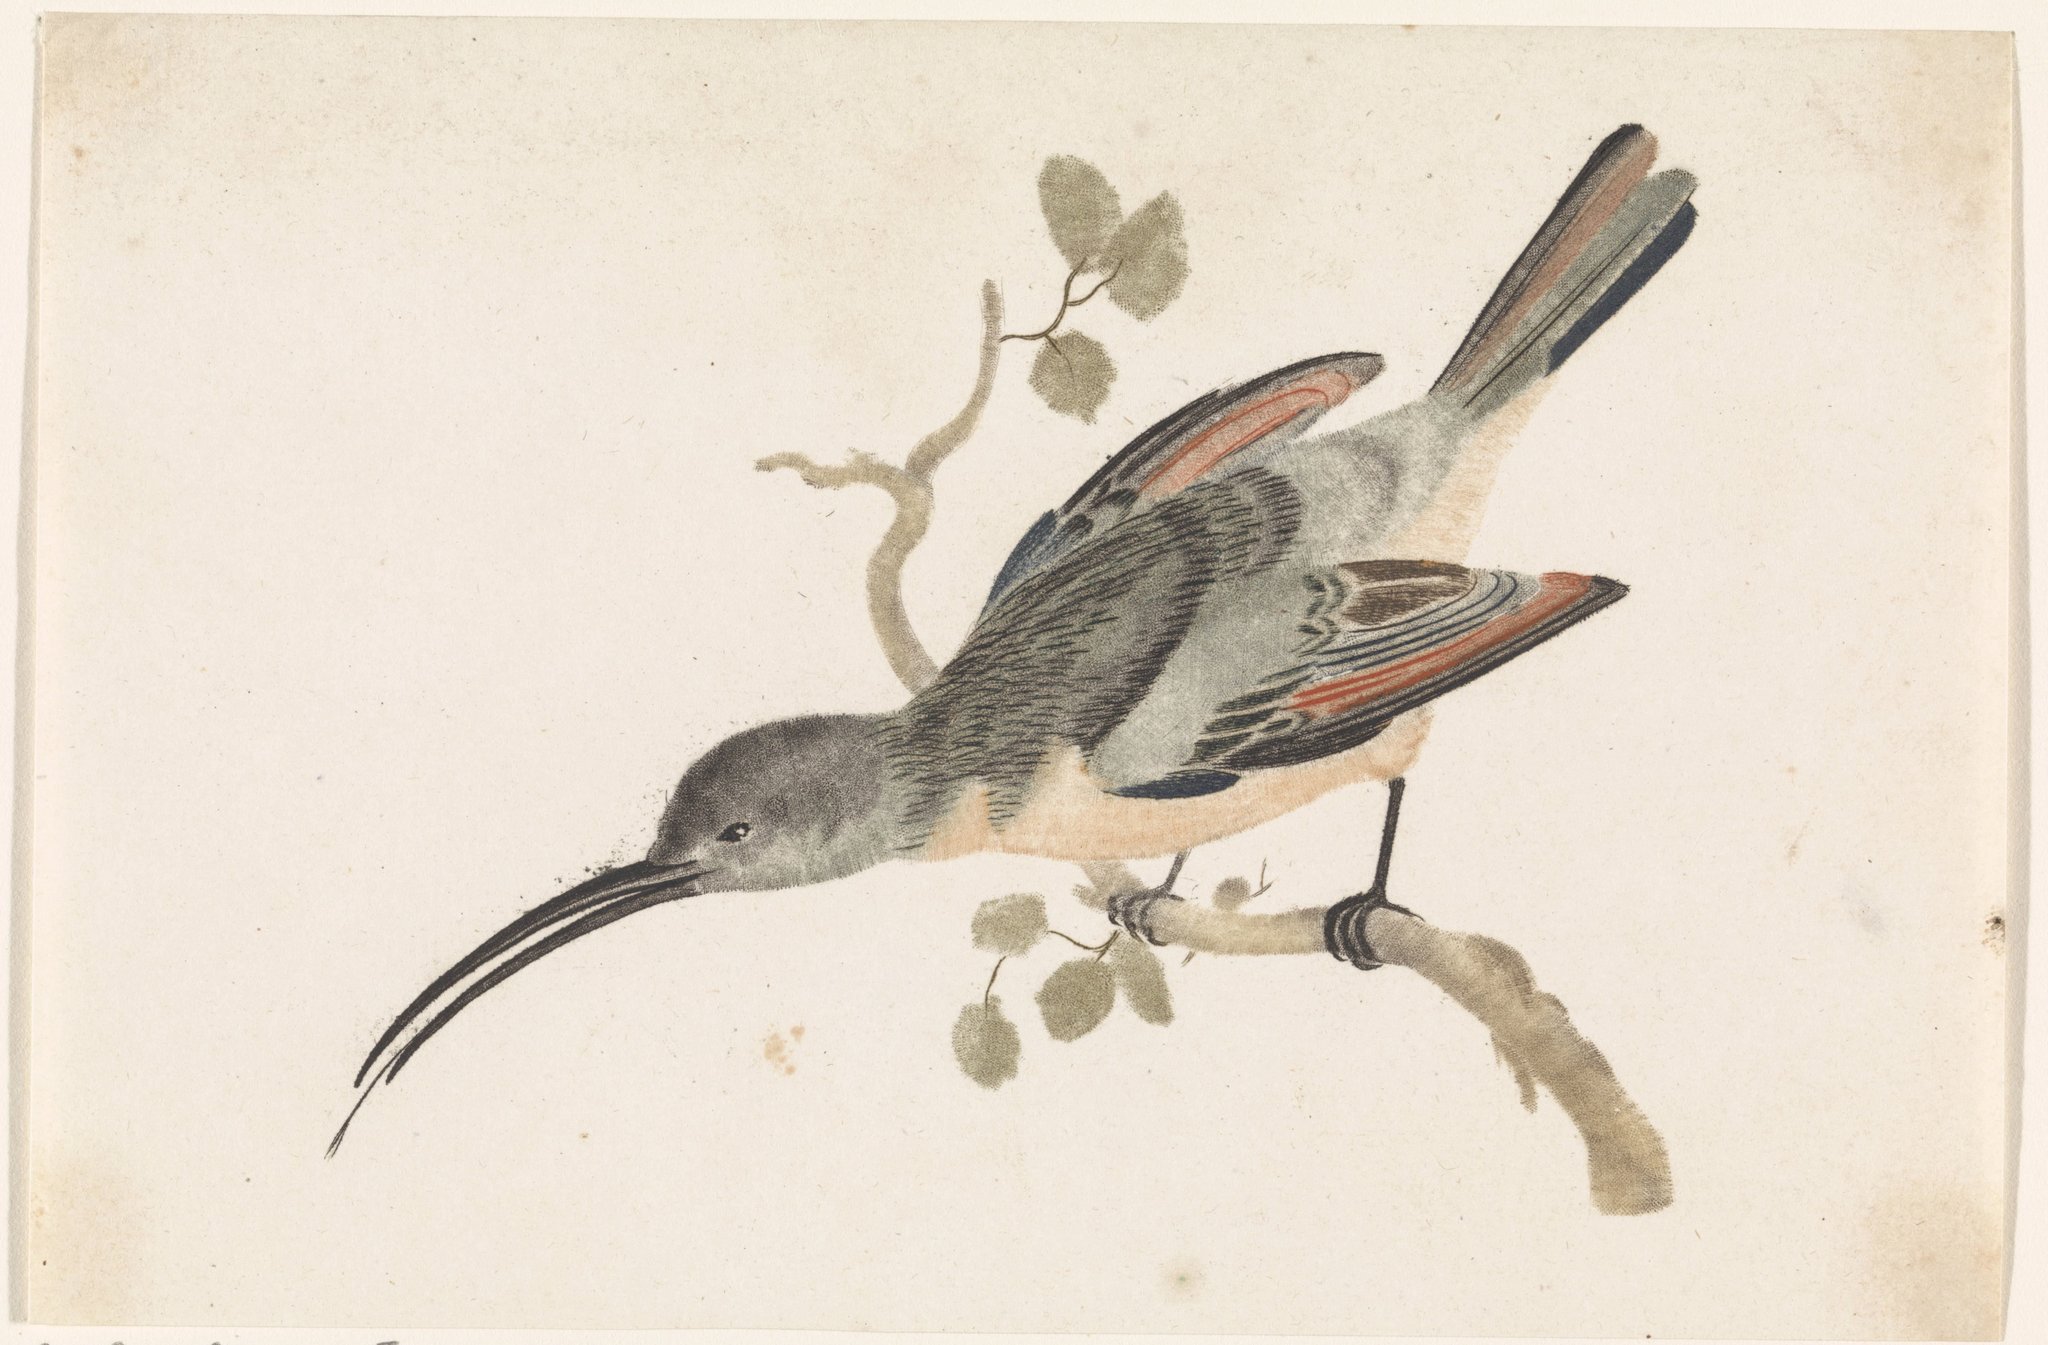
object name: print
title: Kolibrie op een tak naar links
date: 1688-1698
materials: paper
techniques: printing, engraving, lithography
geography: netherlands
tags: other birds (with name)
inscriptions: collector's mark: Lugt 2228